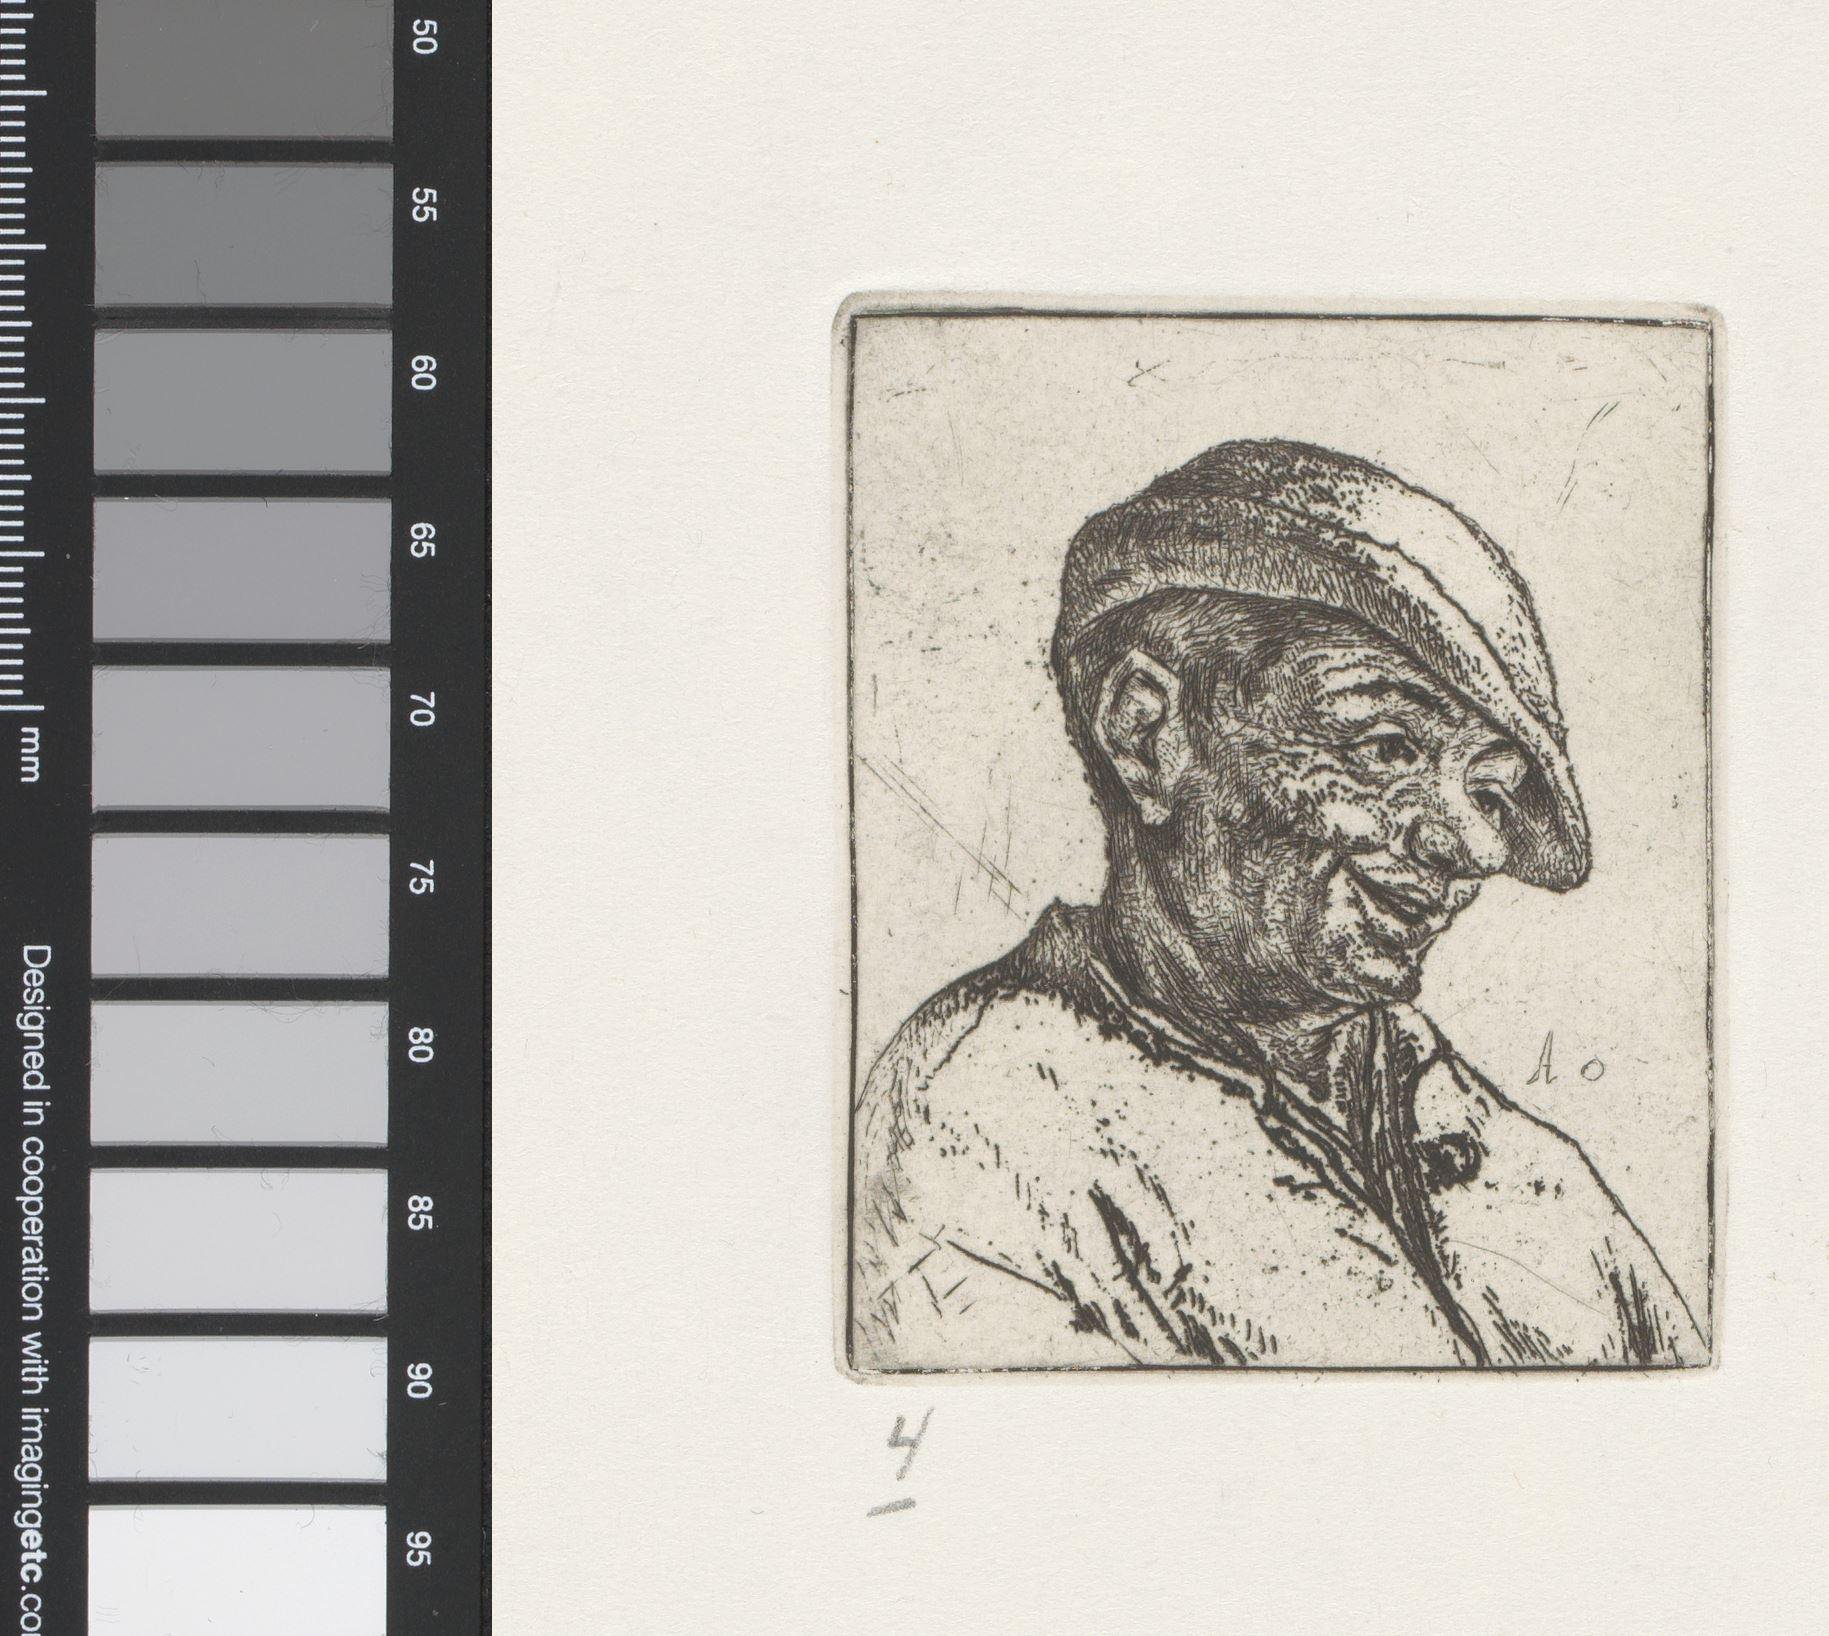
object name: print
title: Buste van een lachende boer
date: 1660-1670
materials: paper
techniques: etching, galvanization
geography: haarlem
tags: laughing, male sex; man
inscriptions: collector's mark: ‘B’, collector's mark: ‘RIJKS / MUSM’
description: De prent maakt deel uit van een portefeuille en is met een andere prent op één albumblad gedrukt.